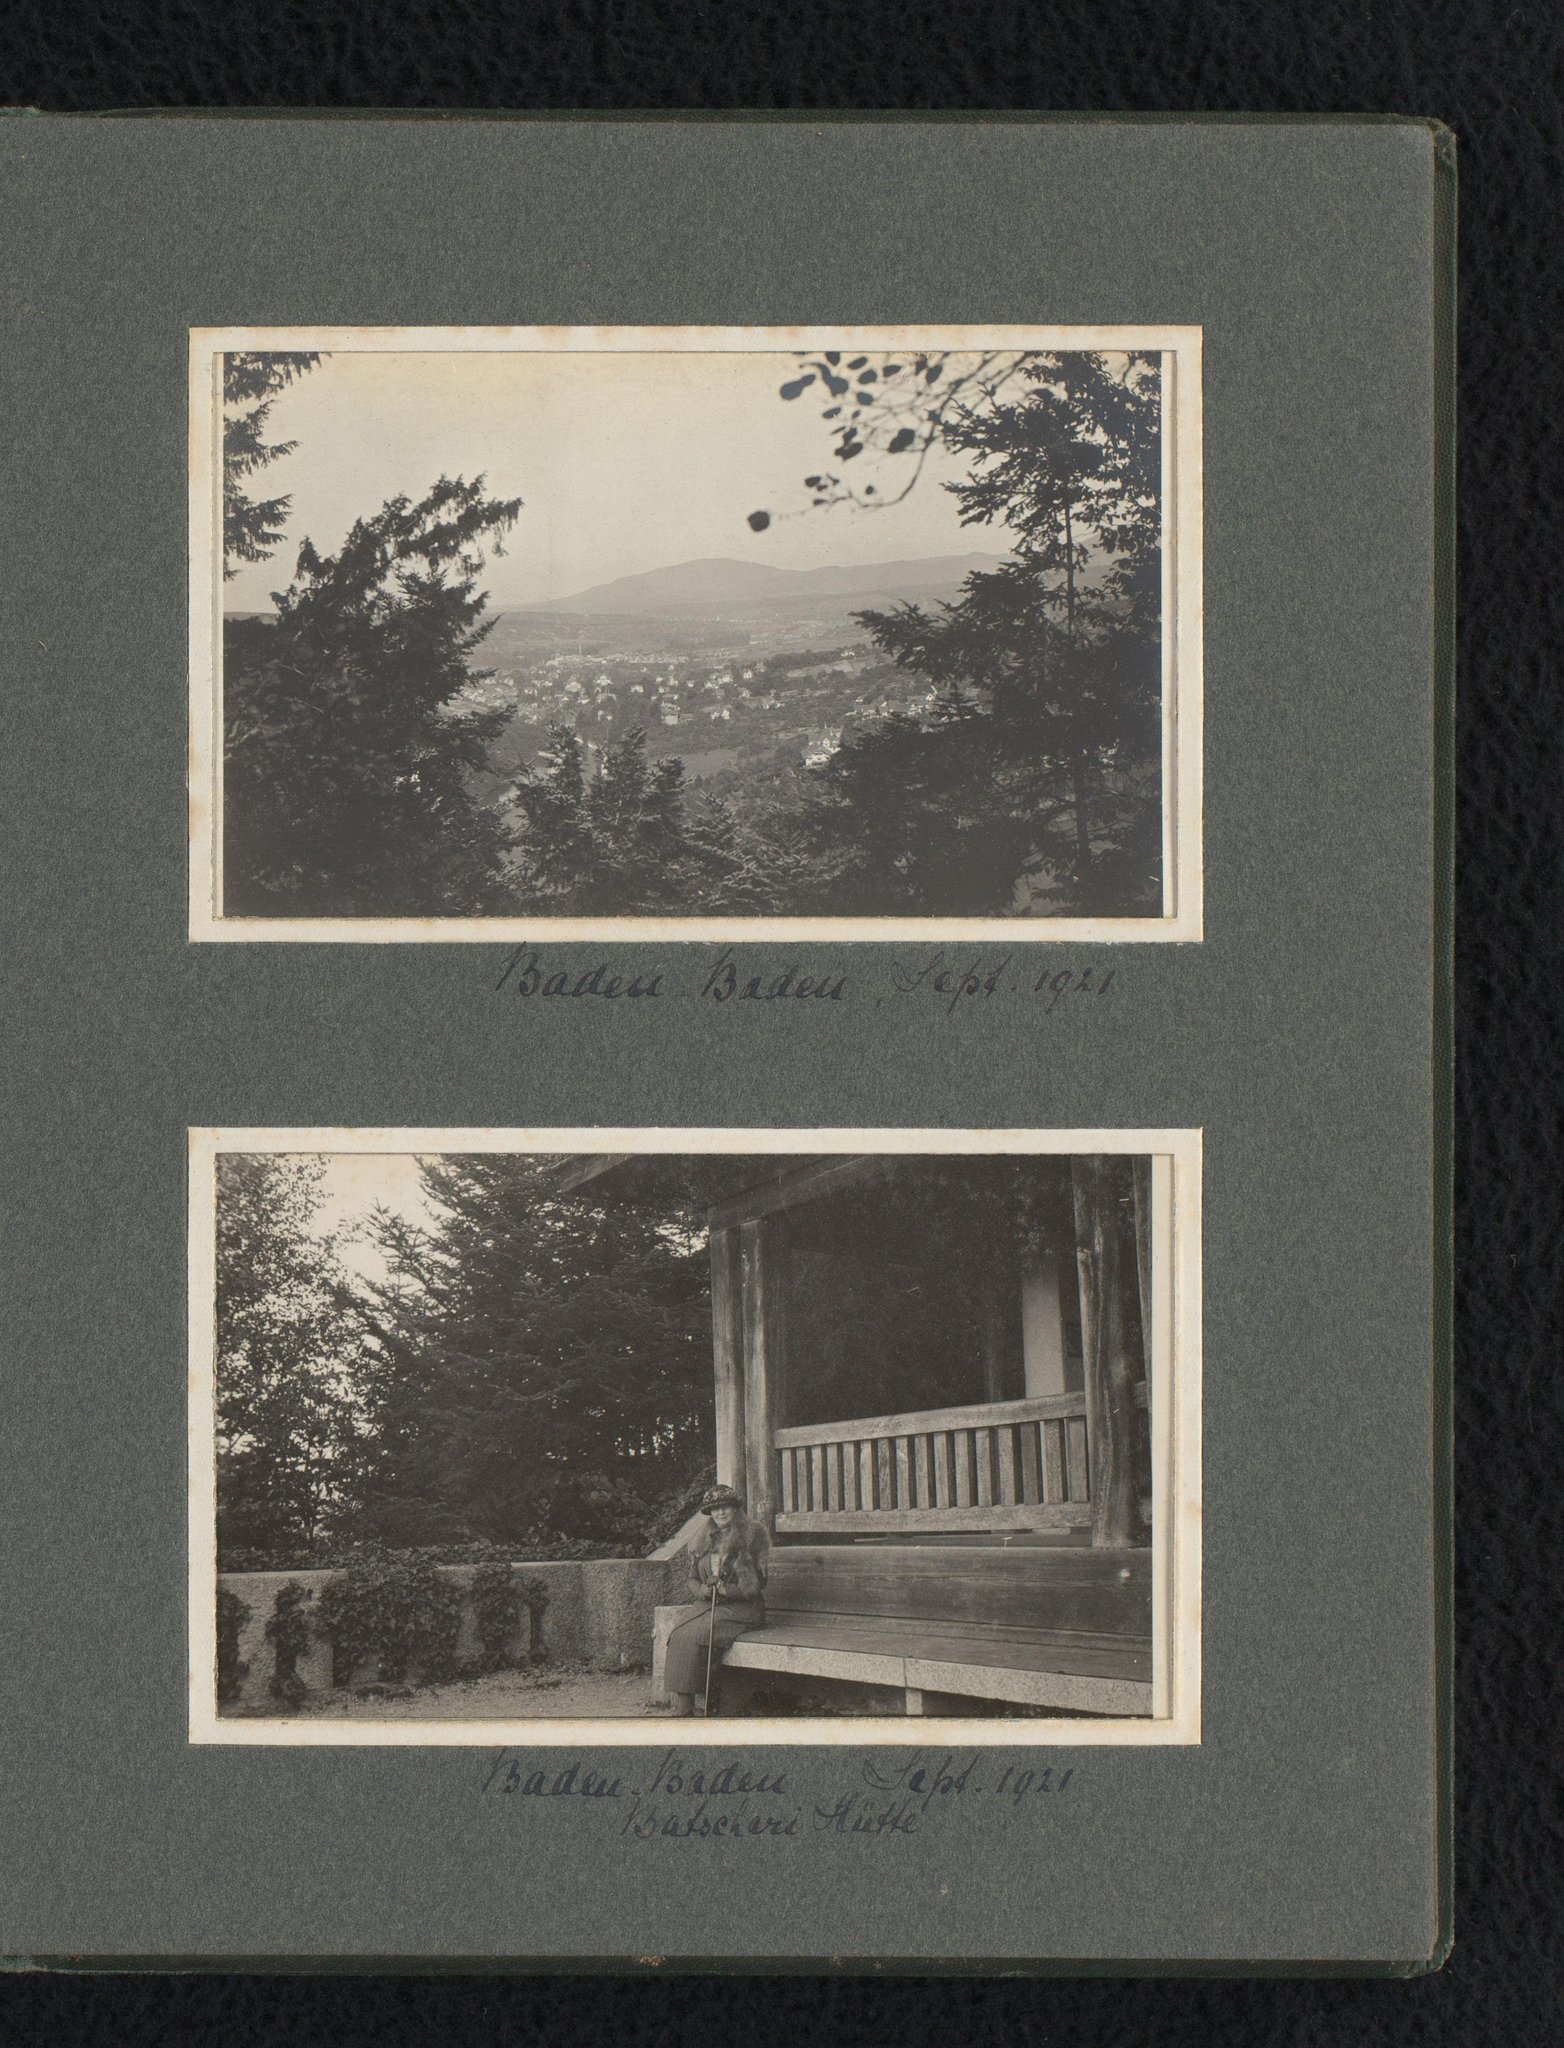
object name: album leaf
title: Twee foto's van een gezicht op Baden-Baden en Caroline van den Berg voor Waldhaus Batschari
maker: hendrik herman van den berg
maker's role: amateurfotograaf, jurist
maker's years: 1875-1944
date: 1909-1921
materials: paper, cardboard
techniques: gelatin silver print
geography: baden-baden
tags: the hague, caroline louise van den berg-van den berg, historical persons, hut, cabin, lodge, prospect of city, town panorama, silhouette of city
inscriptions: caption: ‘Baden-Baden Sept 1921/ Baden-Baden Sept 1921/ Batschari Hütte’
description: Deze foto's maken deel uit van een album.